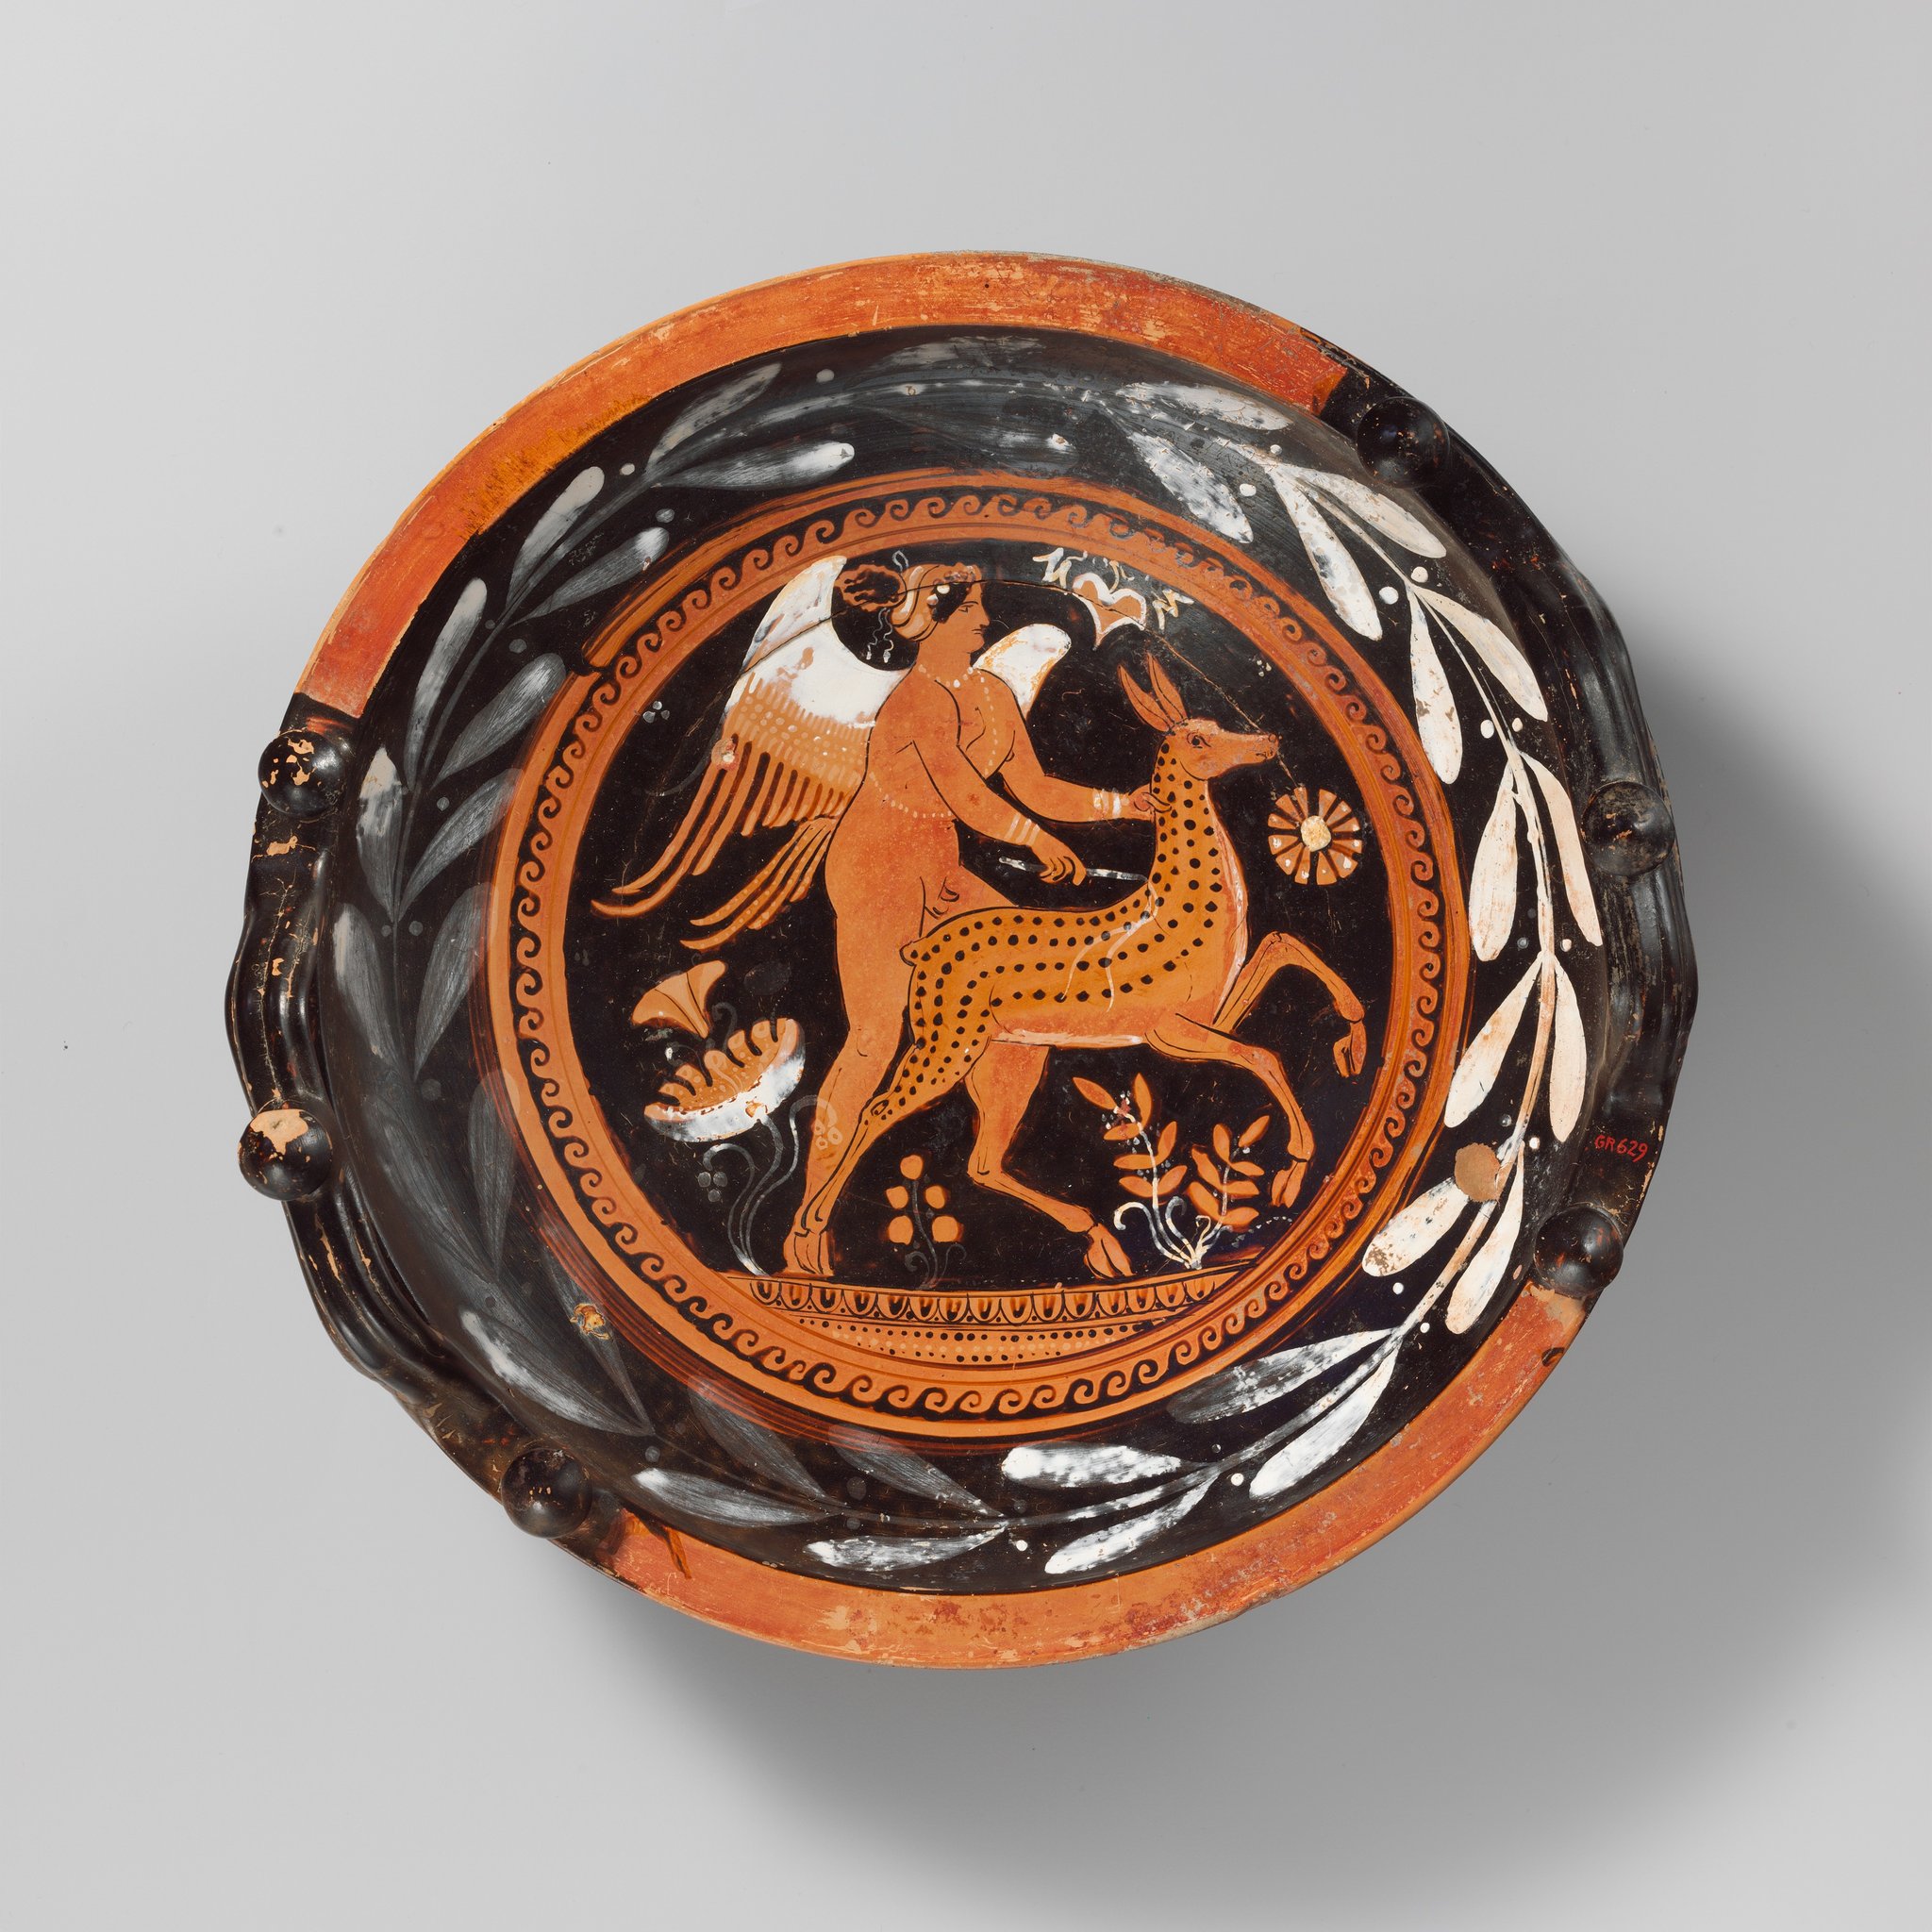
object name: lekanis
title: Terracotta lekanis (dish)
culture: greek, south italian, apulian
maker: group of bologna 585/trieste s 403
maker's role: artist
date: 340-320 BCE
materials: terracotta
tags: eros,deer